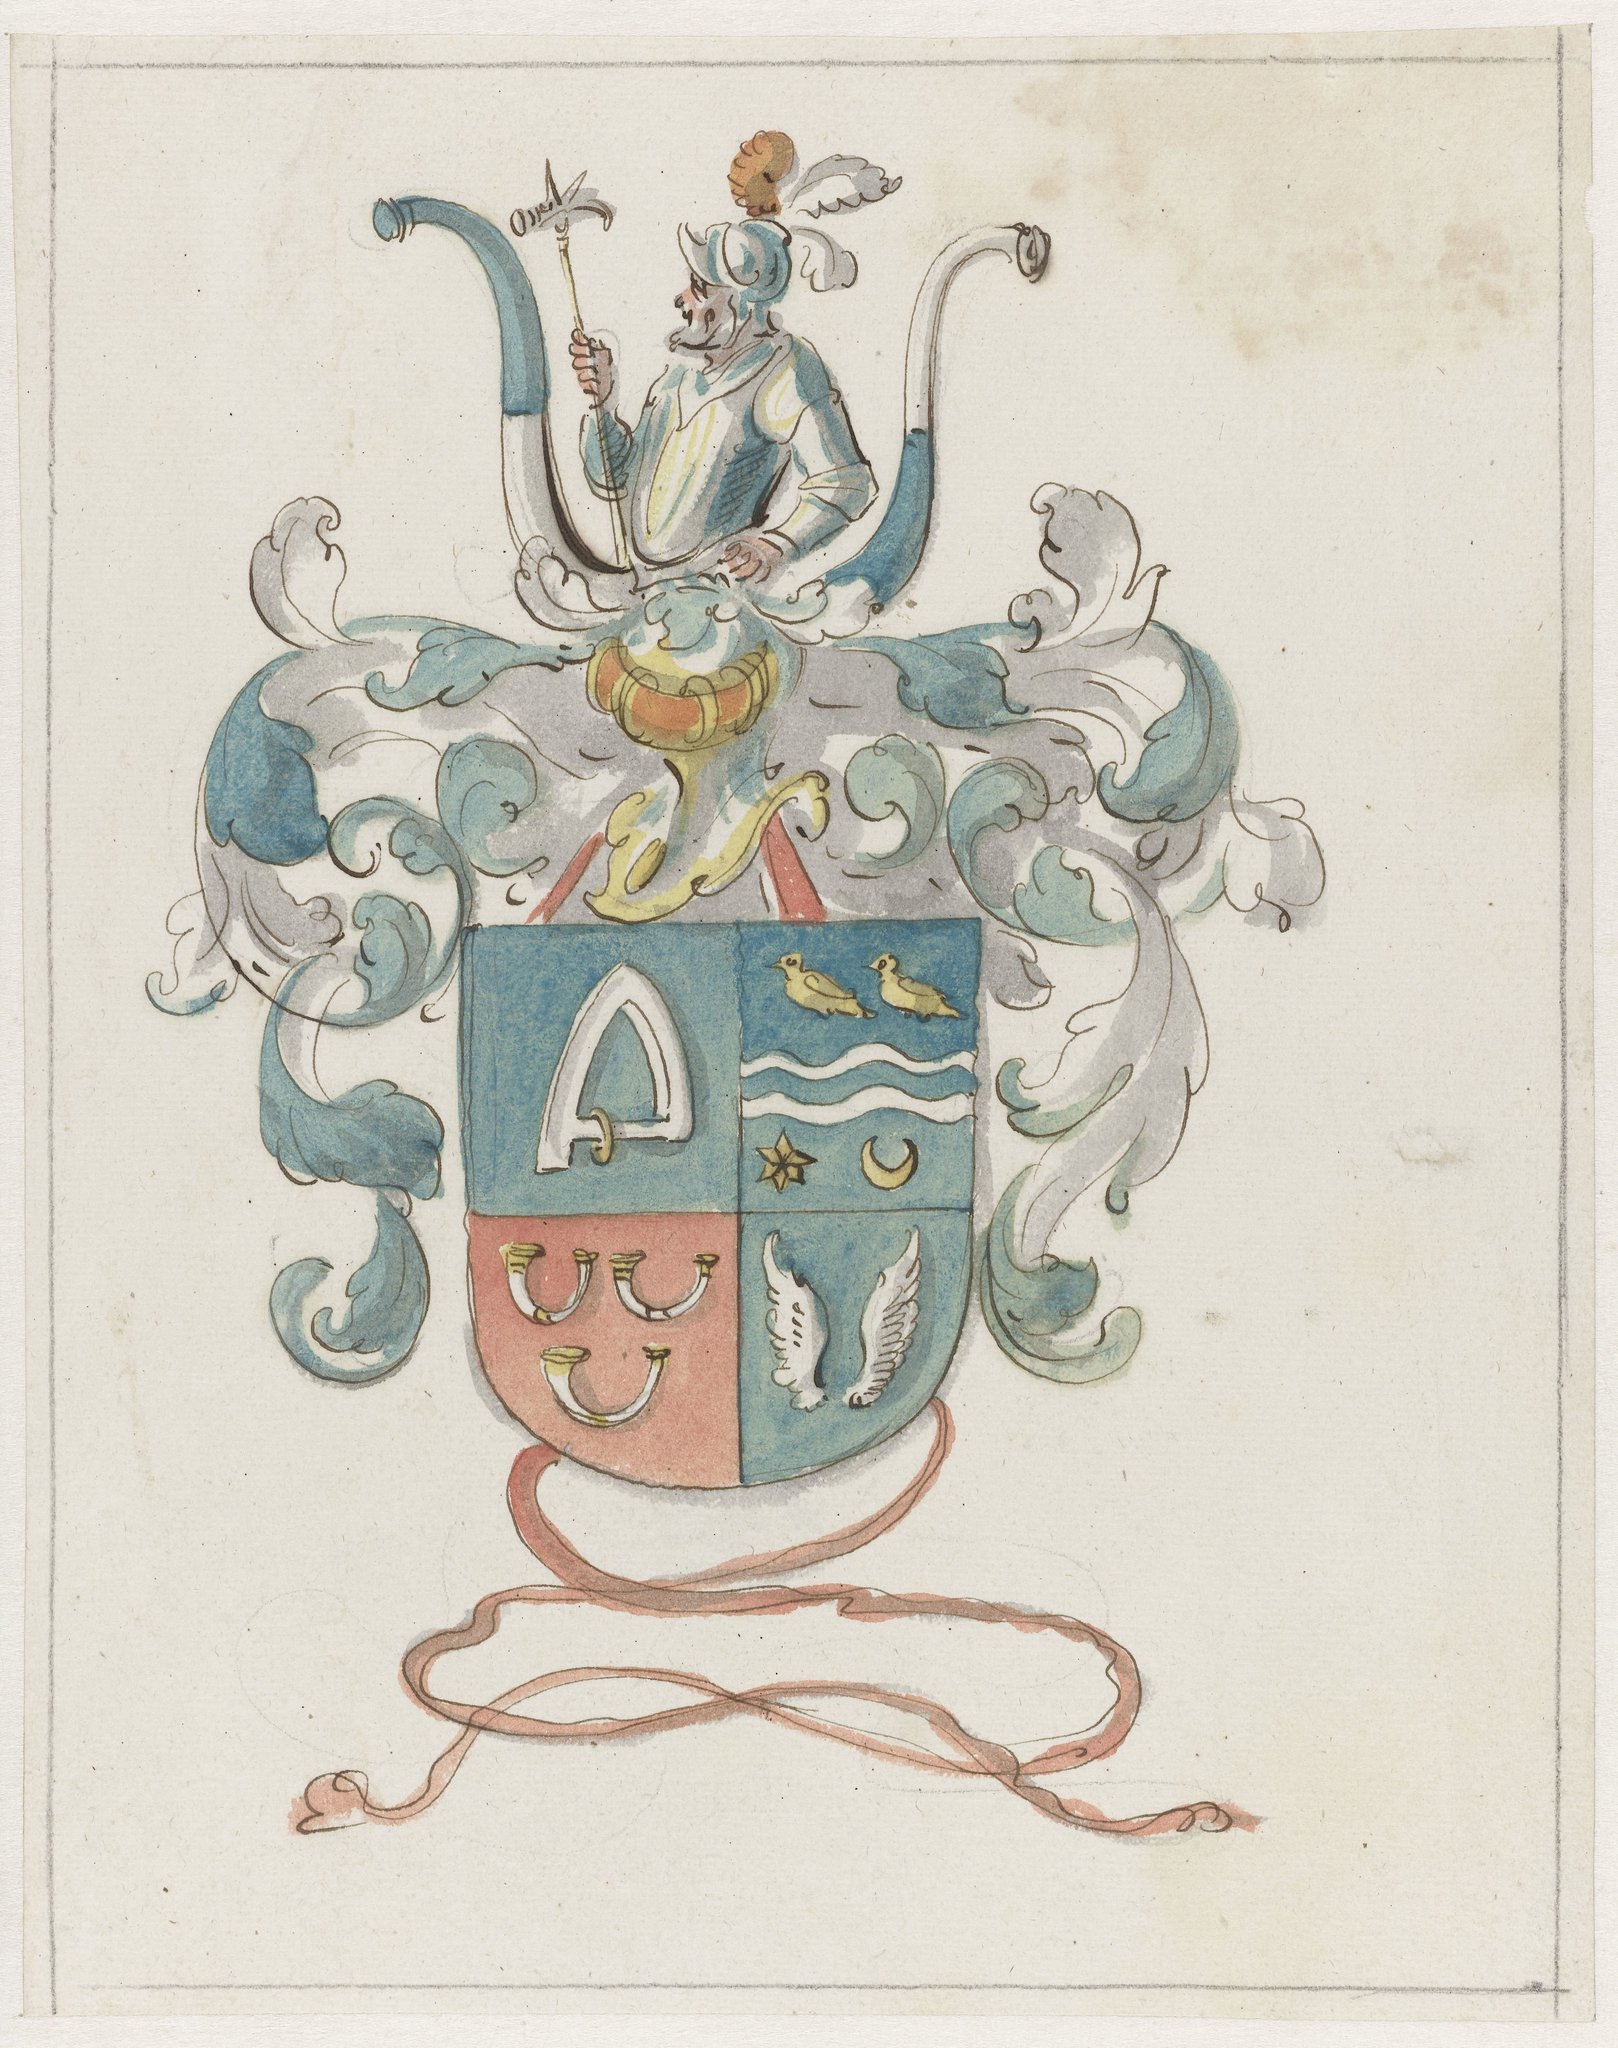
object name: drawing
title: Wapenschild van de familie Overlander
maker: pieter jansz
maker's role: draughtsman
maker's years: 1602-1672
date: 1660-1672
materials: chalk, graphite, ink, paper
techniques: brush, pen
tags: armorial bearing, heraldry